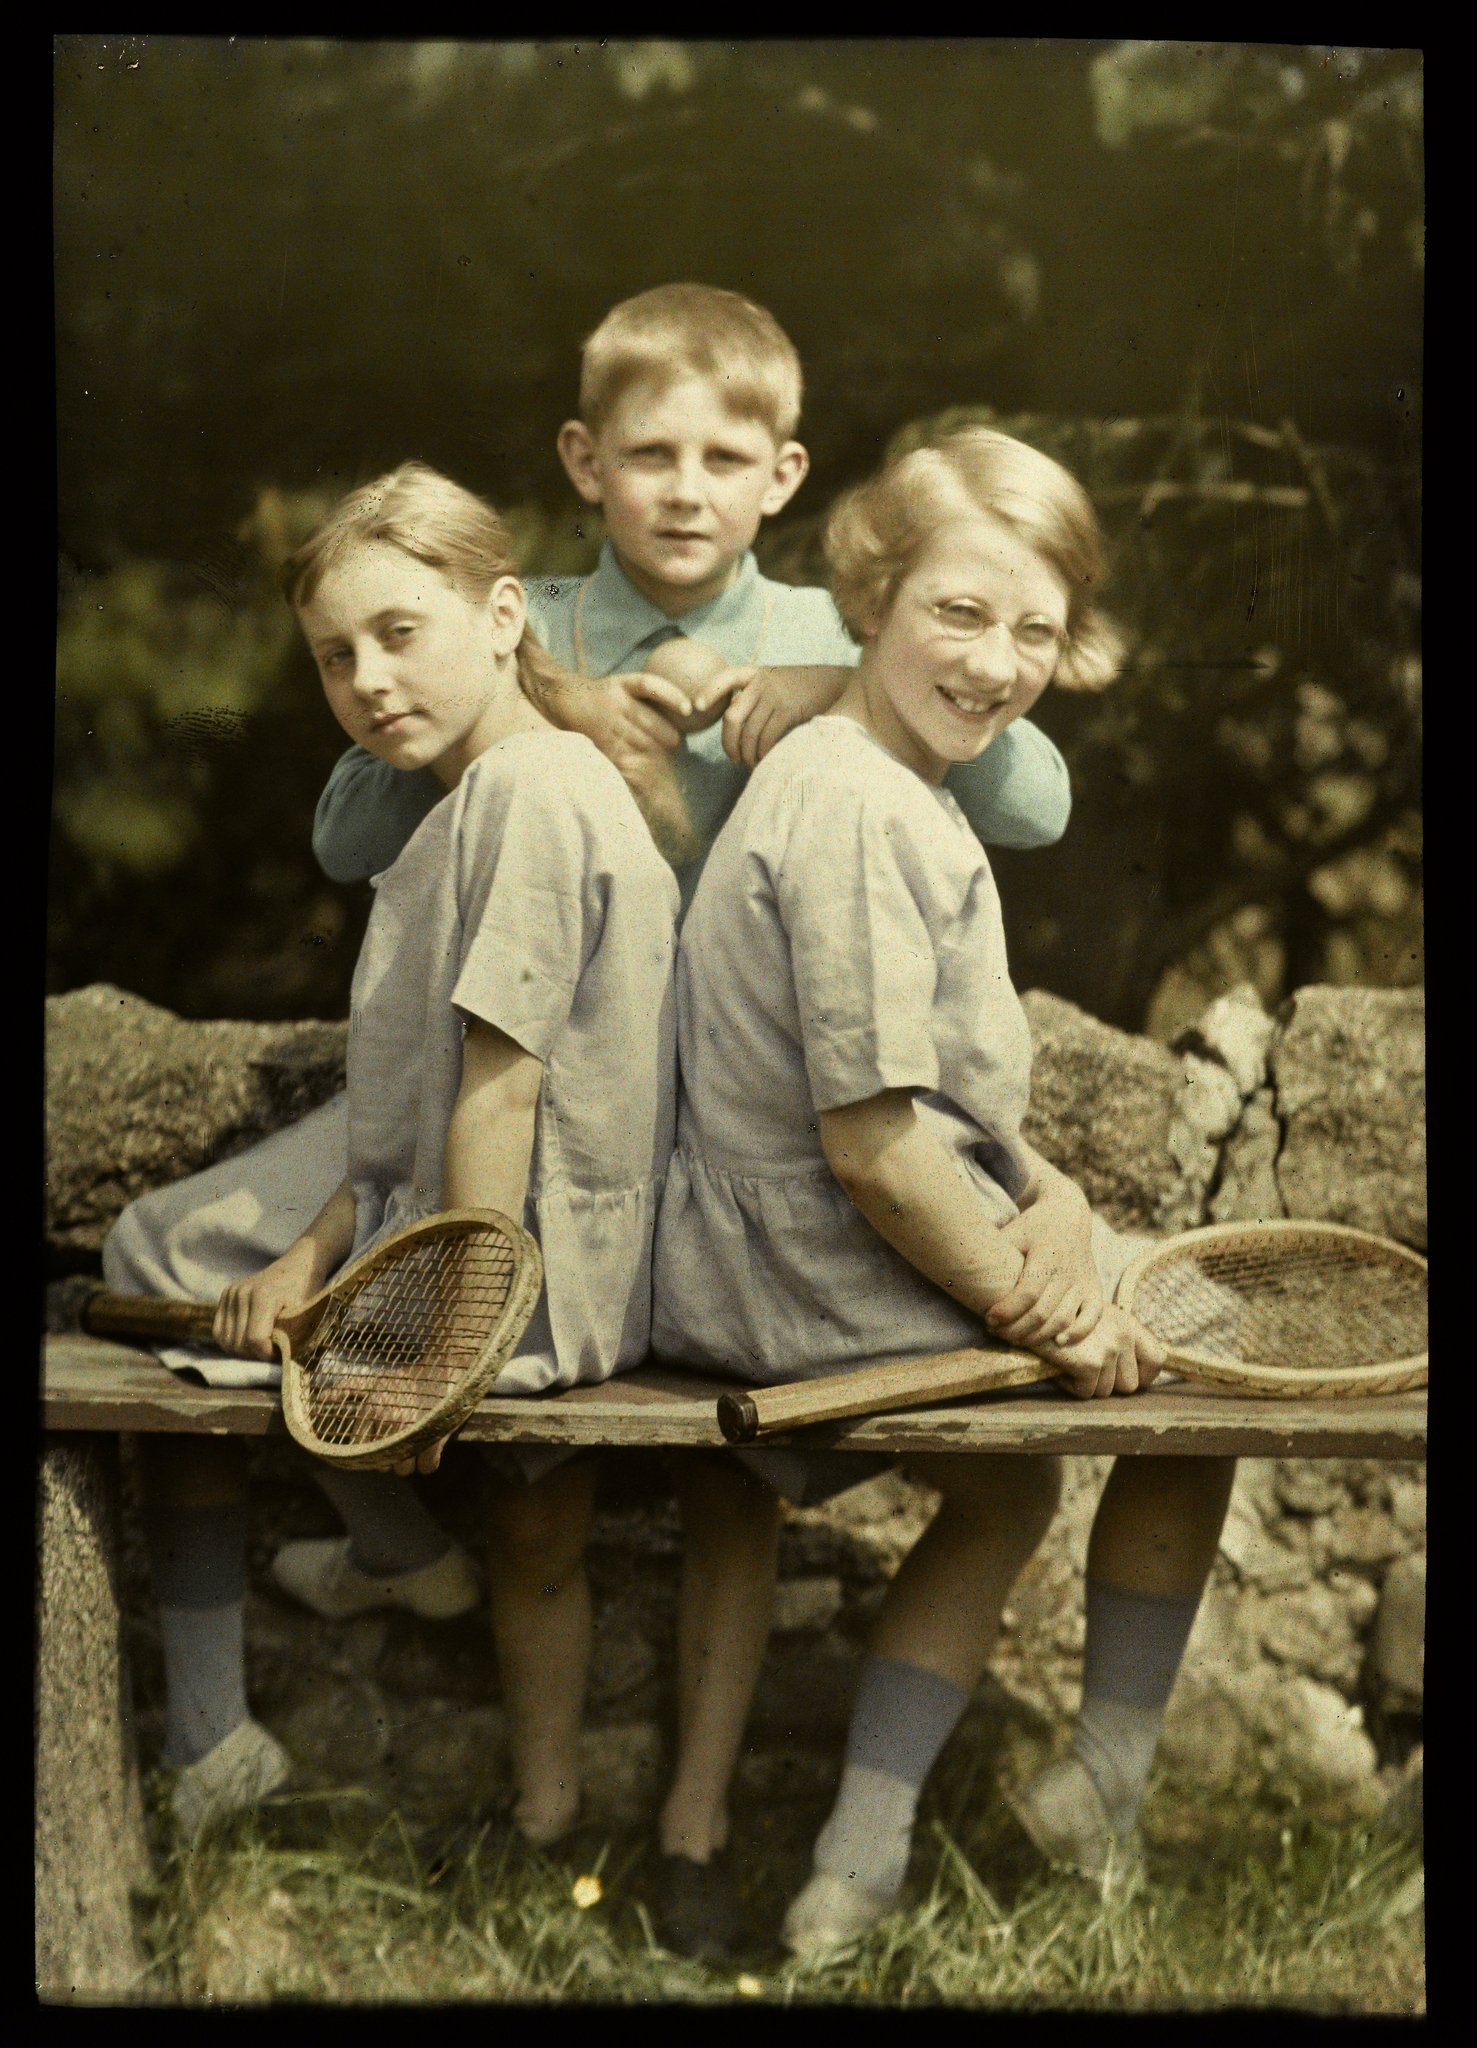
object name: color slide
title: Portret van twee meisjes met tennisrackets en een jongetje met tennisbal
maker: Anonymous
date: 1907-1930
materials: glass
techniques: autochrome process, slide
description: Portret van twee op een houten bank zittende meisjes met tennisrackets en een staand jongetje met tennisbal.